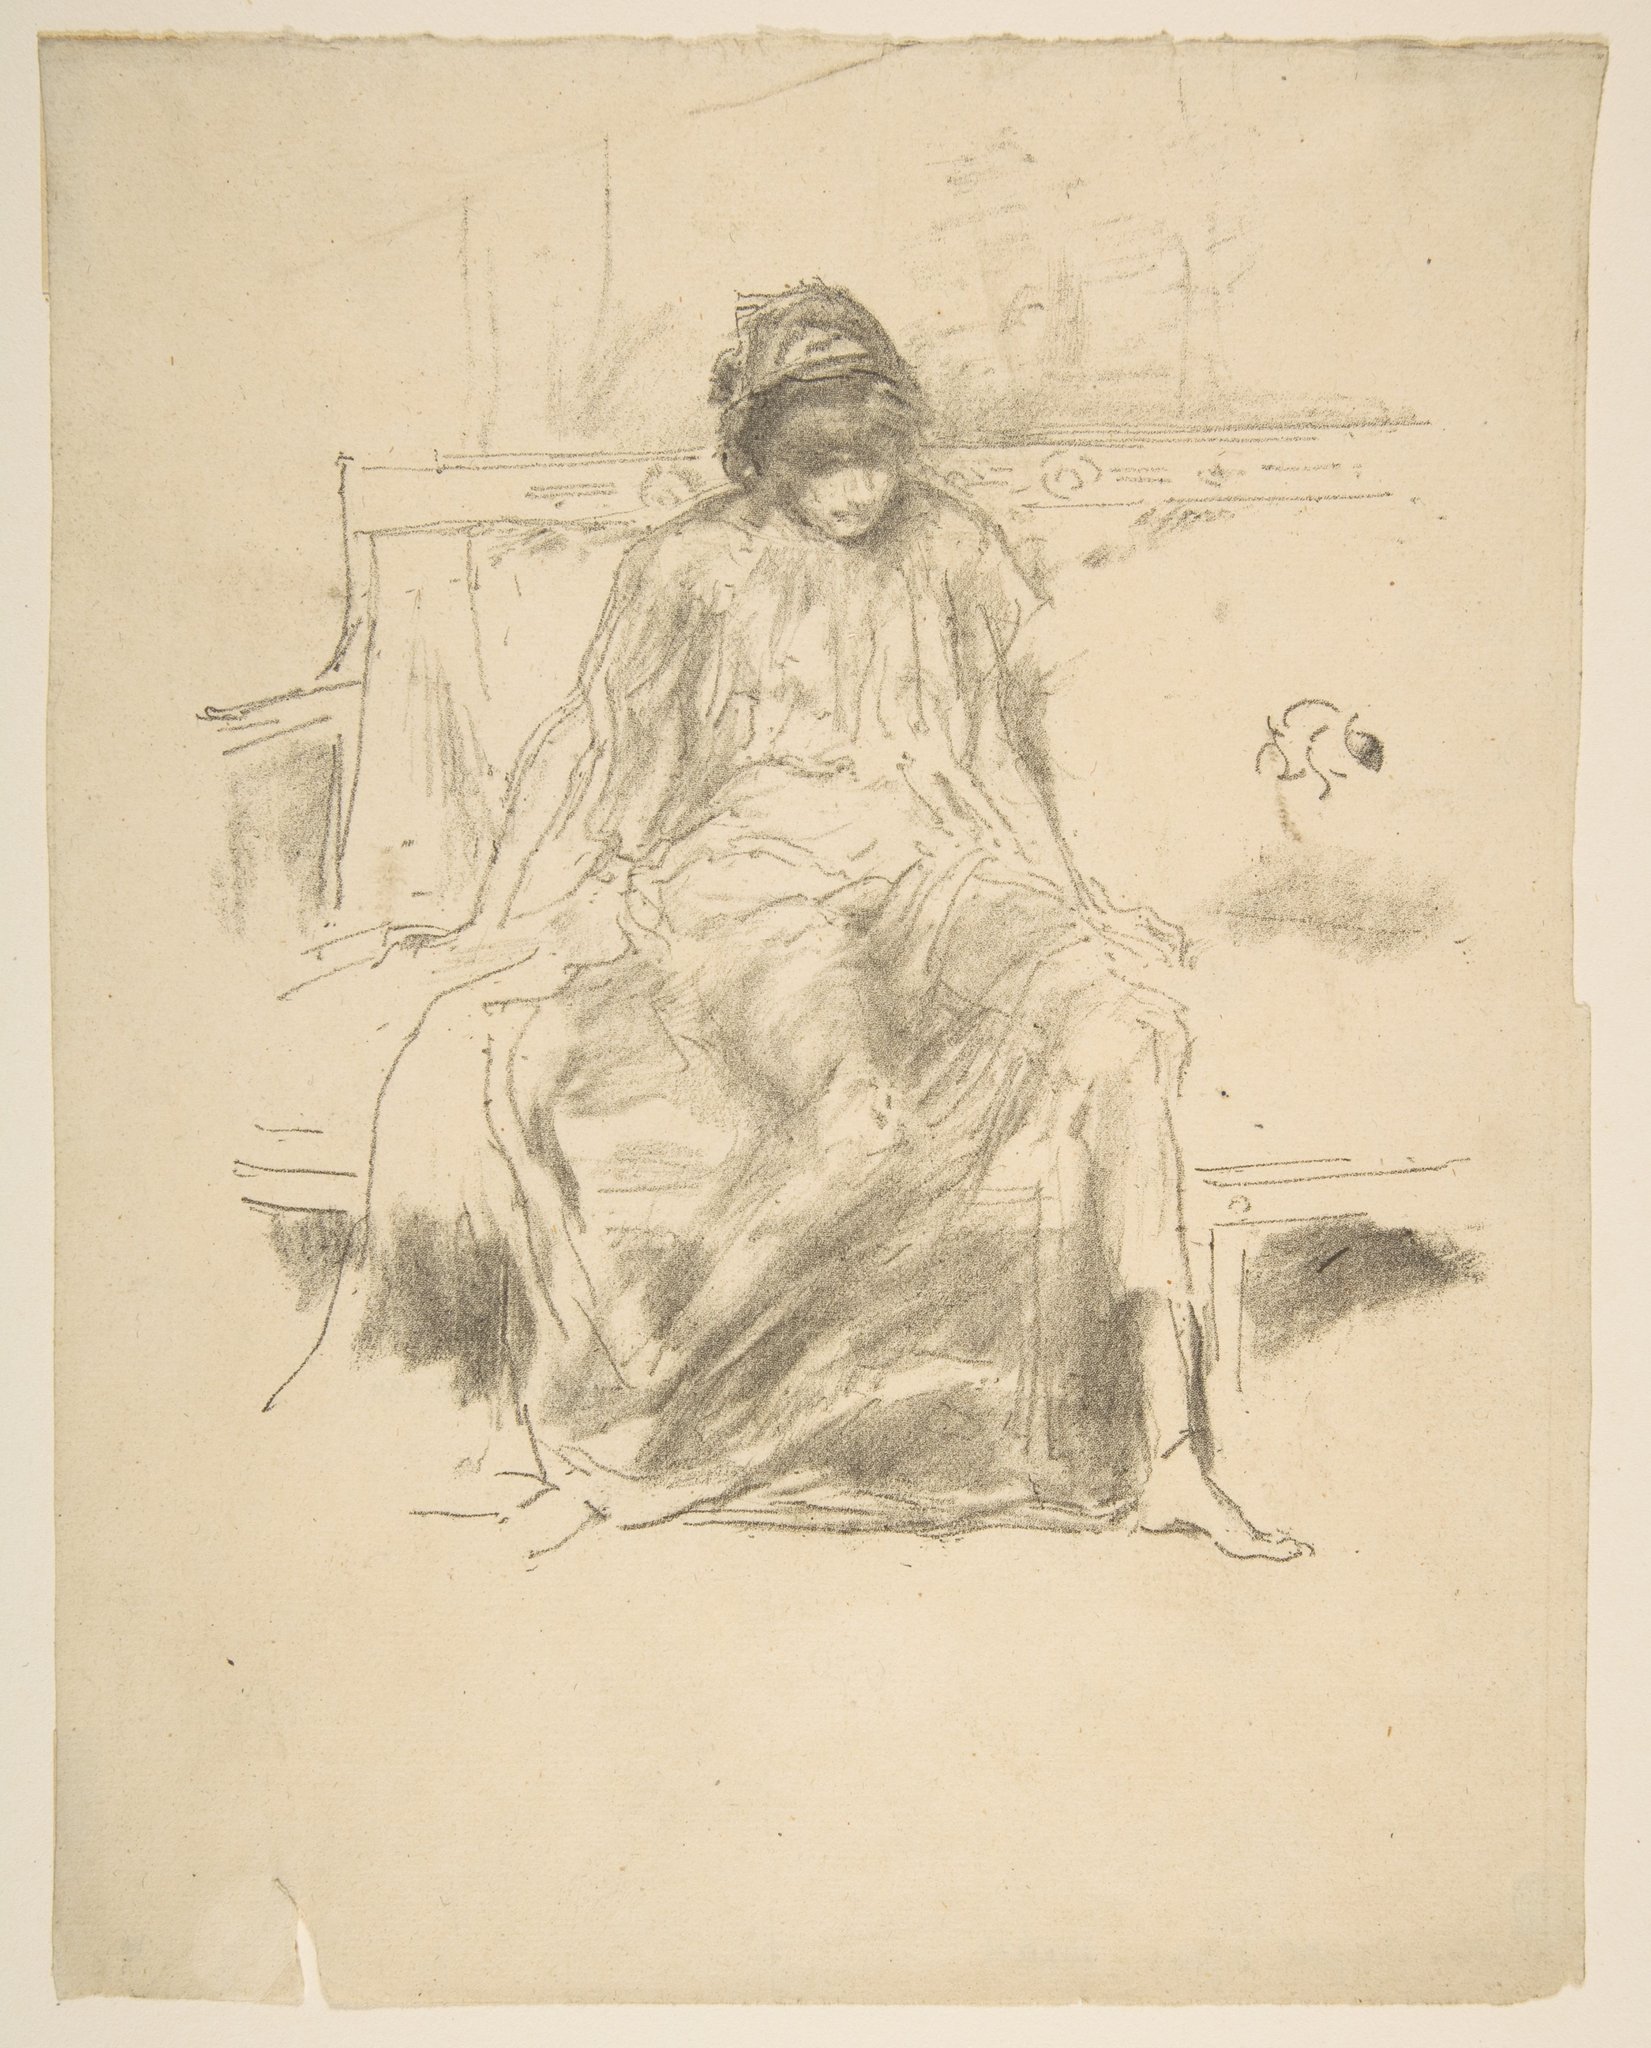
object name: print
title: The Draped Figure, Seated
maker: james mcneill whistler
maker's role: artist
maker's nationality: american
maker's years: 1834-1903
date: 1893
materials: ink, paper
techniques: printing, stumping, lithography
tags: women